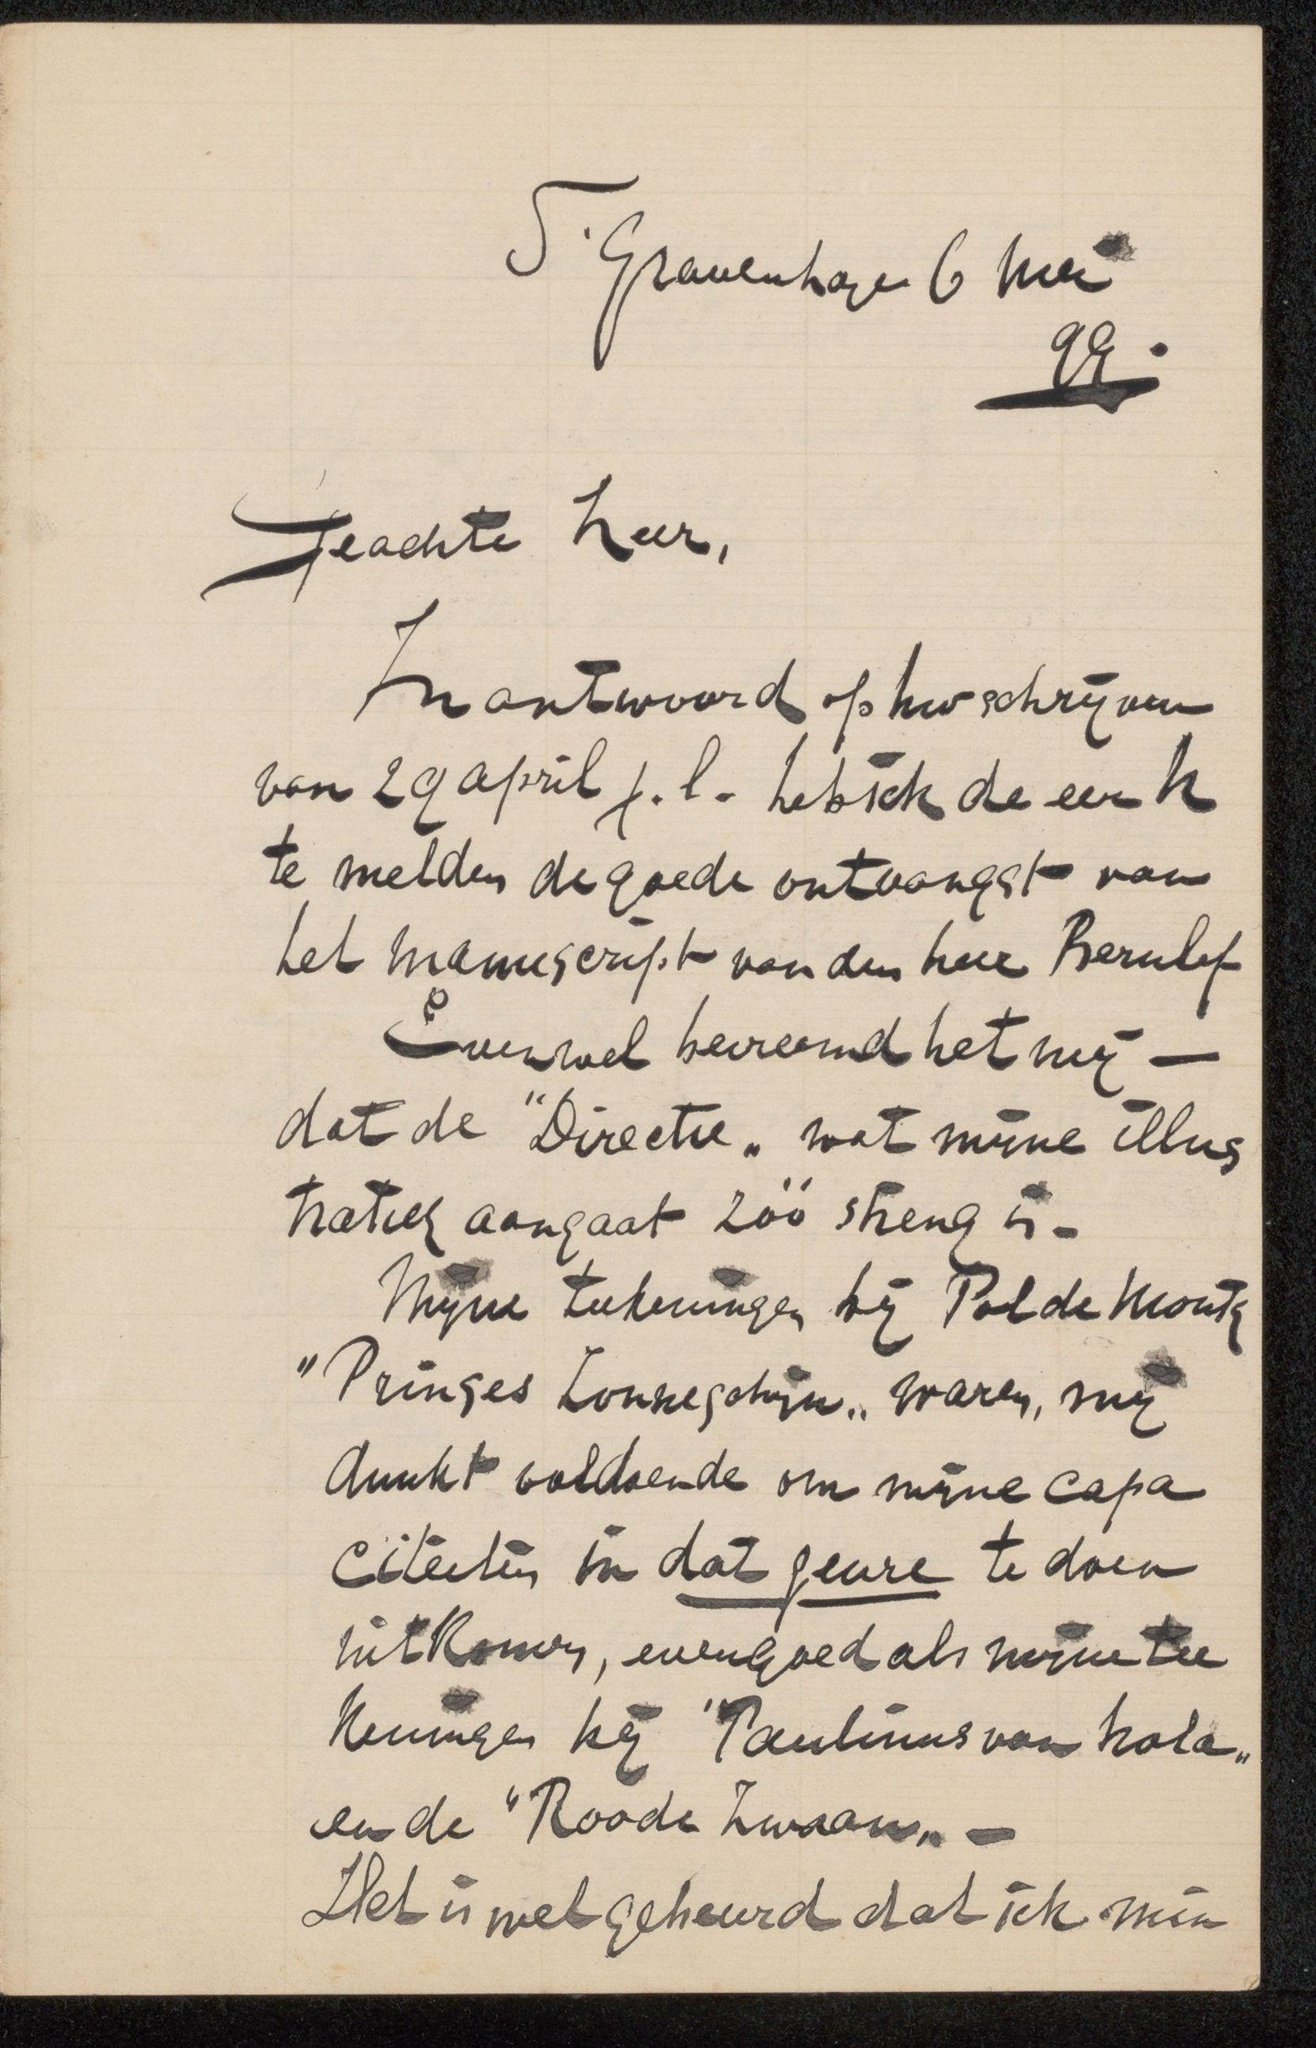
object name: letter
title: Brief aan Philip Zilcken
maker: henricus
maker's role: draughtsman, print maker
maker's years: 1867-1921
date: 1899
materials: ink, paper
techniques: pen, writing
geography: the hague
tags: berlin, pol de mont, the hague, painter, draughtsman, philip zilcken, drawing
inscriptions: collector's mark: ‘RPK’